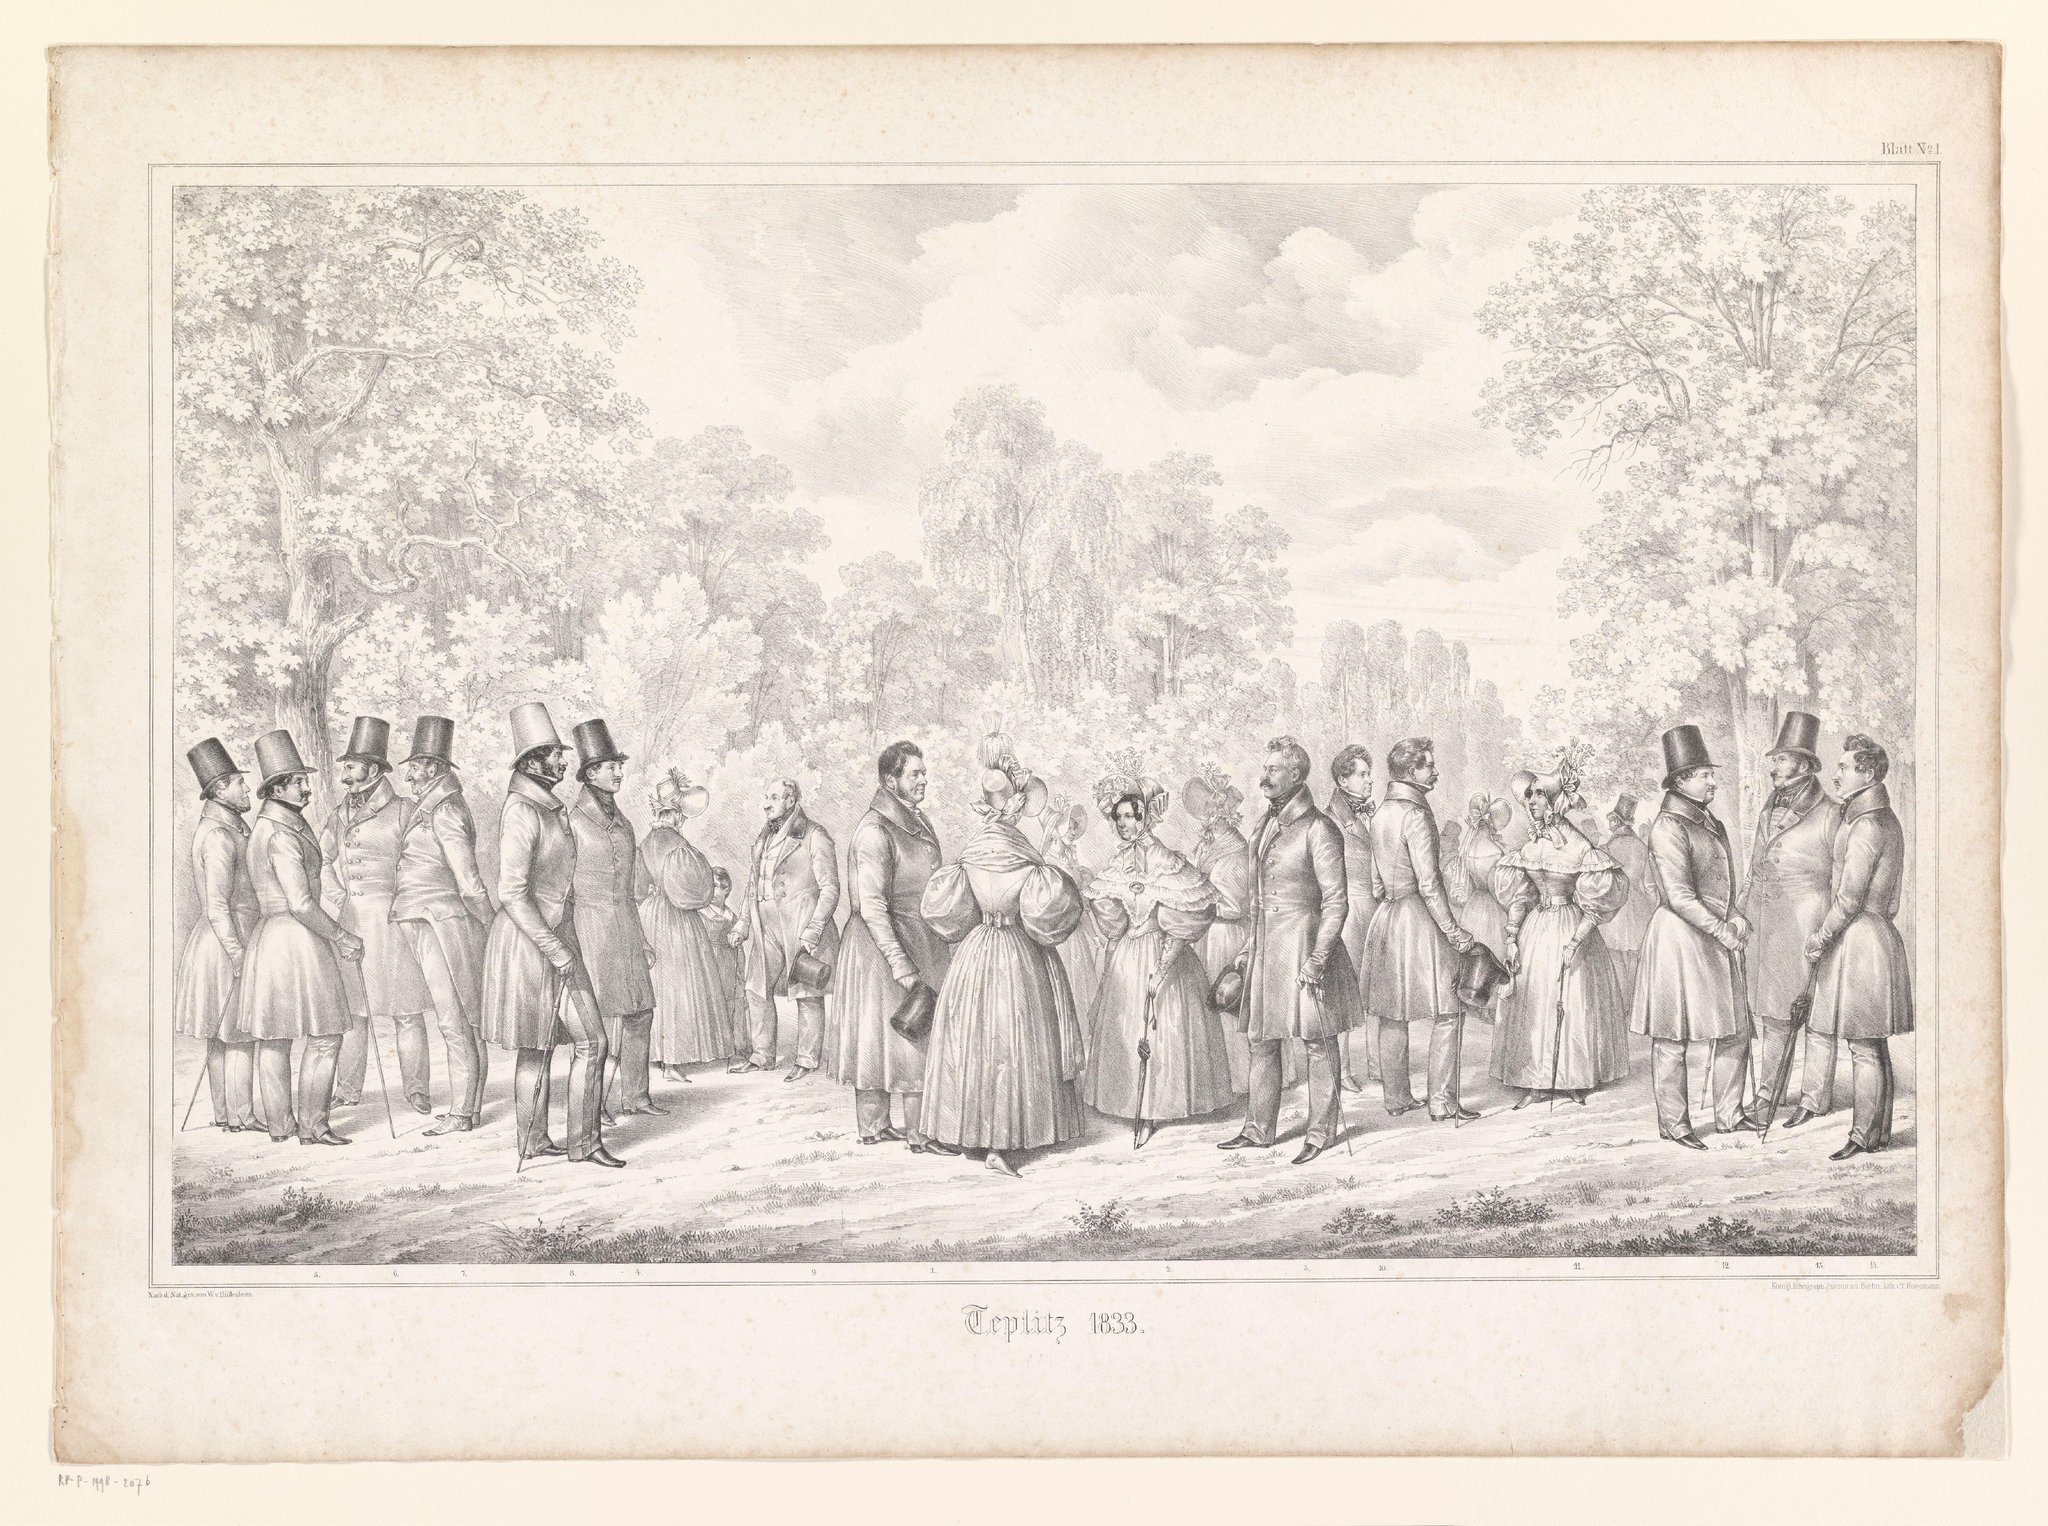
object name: print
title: Erinnerung an Teplitz, Bade Saison 1833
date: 1833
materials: paper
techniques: lithograph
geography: berlin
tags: adult man (+ more than eight persons), adult woman (+ seven persons), historical persons, landscapes (+ landscape with figures, staffage)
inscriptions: collector's mark: Lugt 2228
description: Portretten van Karl August van Saksen-Weimar-Eisenach, Auguste Fürstin von Liegnitz, Karel hertog van Mecklenburg-Strelitz, Albert van Mecklenburg-Schwerin, Buchholz, Schenkendorff, Von der Reck, Friedrich von Thun und Hohenstein, Trubetzkoi, Von Bülow en zijn vrouw, Bartikow, Kurts en Von Knoblauch.